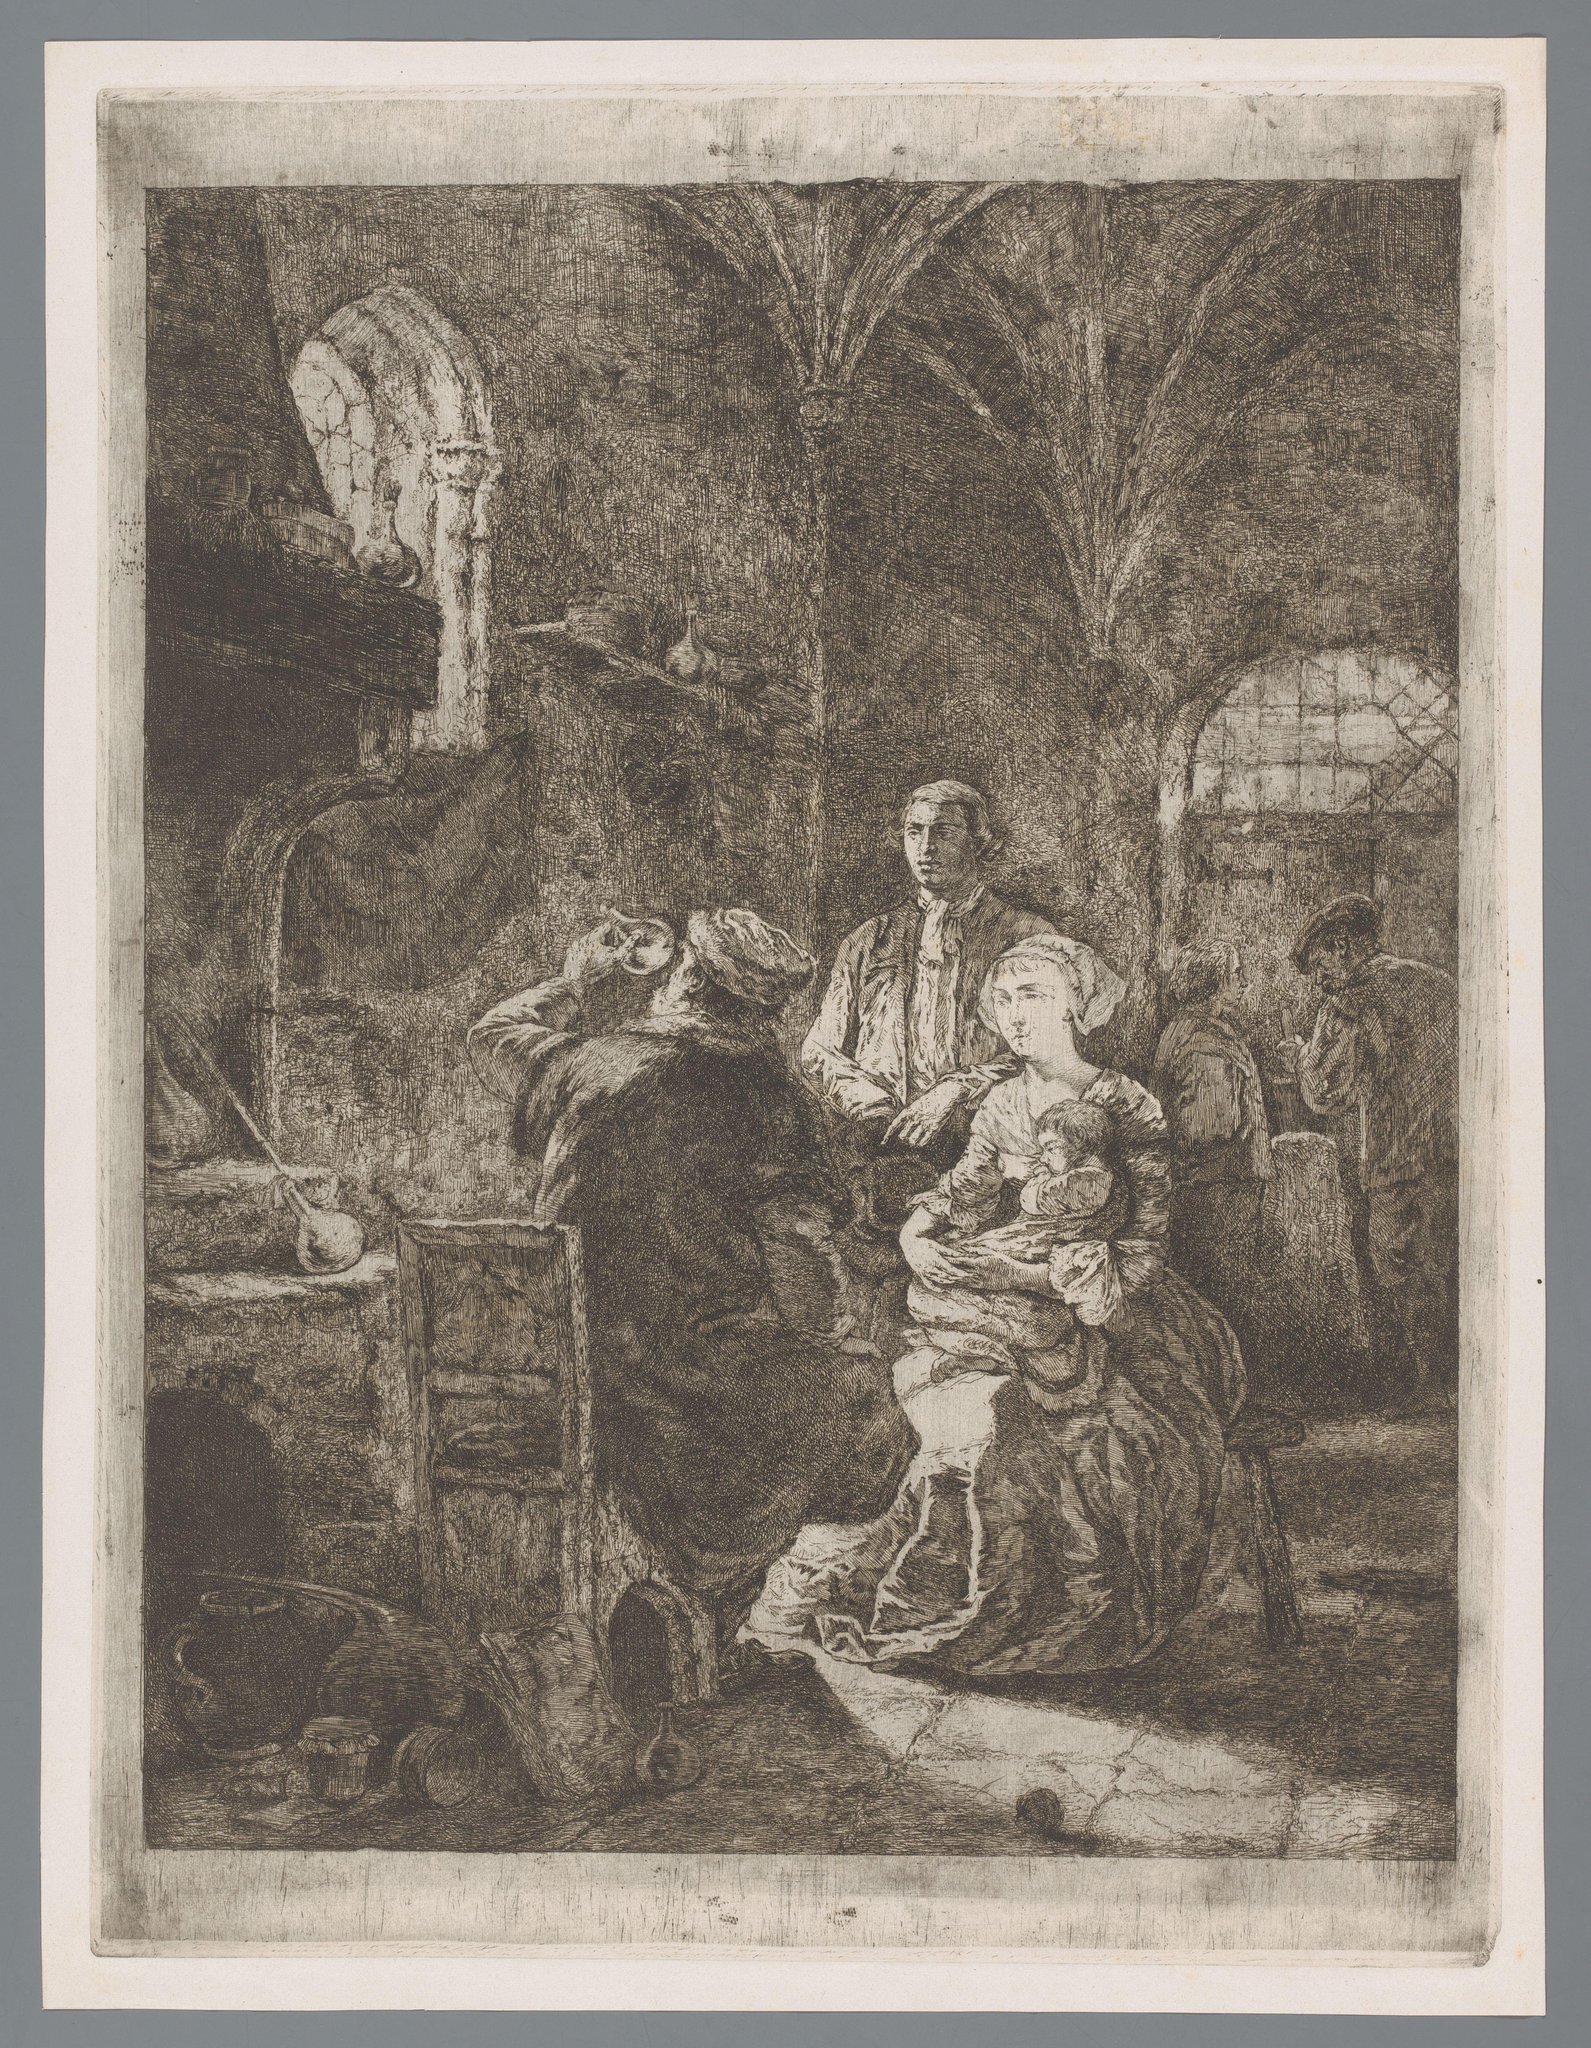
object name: print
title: Gezin met kind bij een dokter die een flesje vloeistof tegen het licht houdt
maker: willem linnig (i)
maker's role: print maker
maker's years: 1819-1885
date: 1829-1885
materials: paper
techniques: etching, intaglio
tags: physician, doctor, container of glass: bottle, jar, vase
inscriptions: collector's mark: Lugt 1485, collector's mark: Lugt 2228